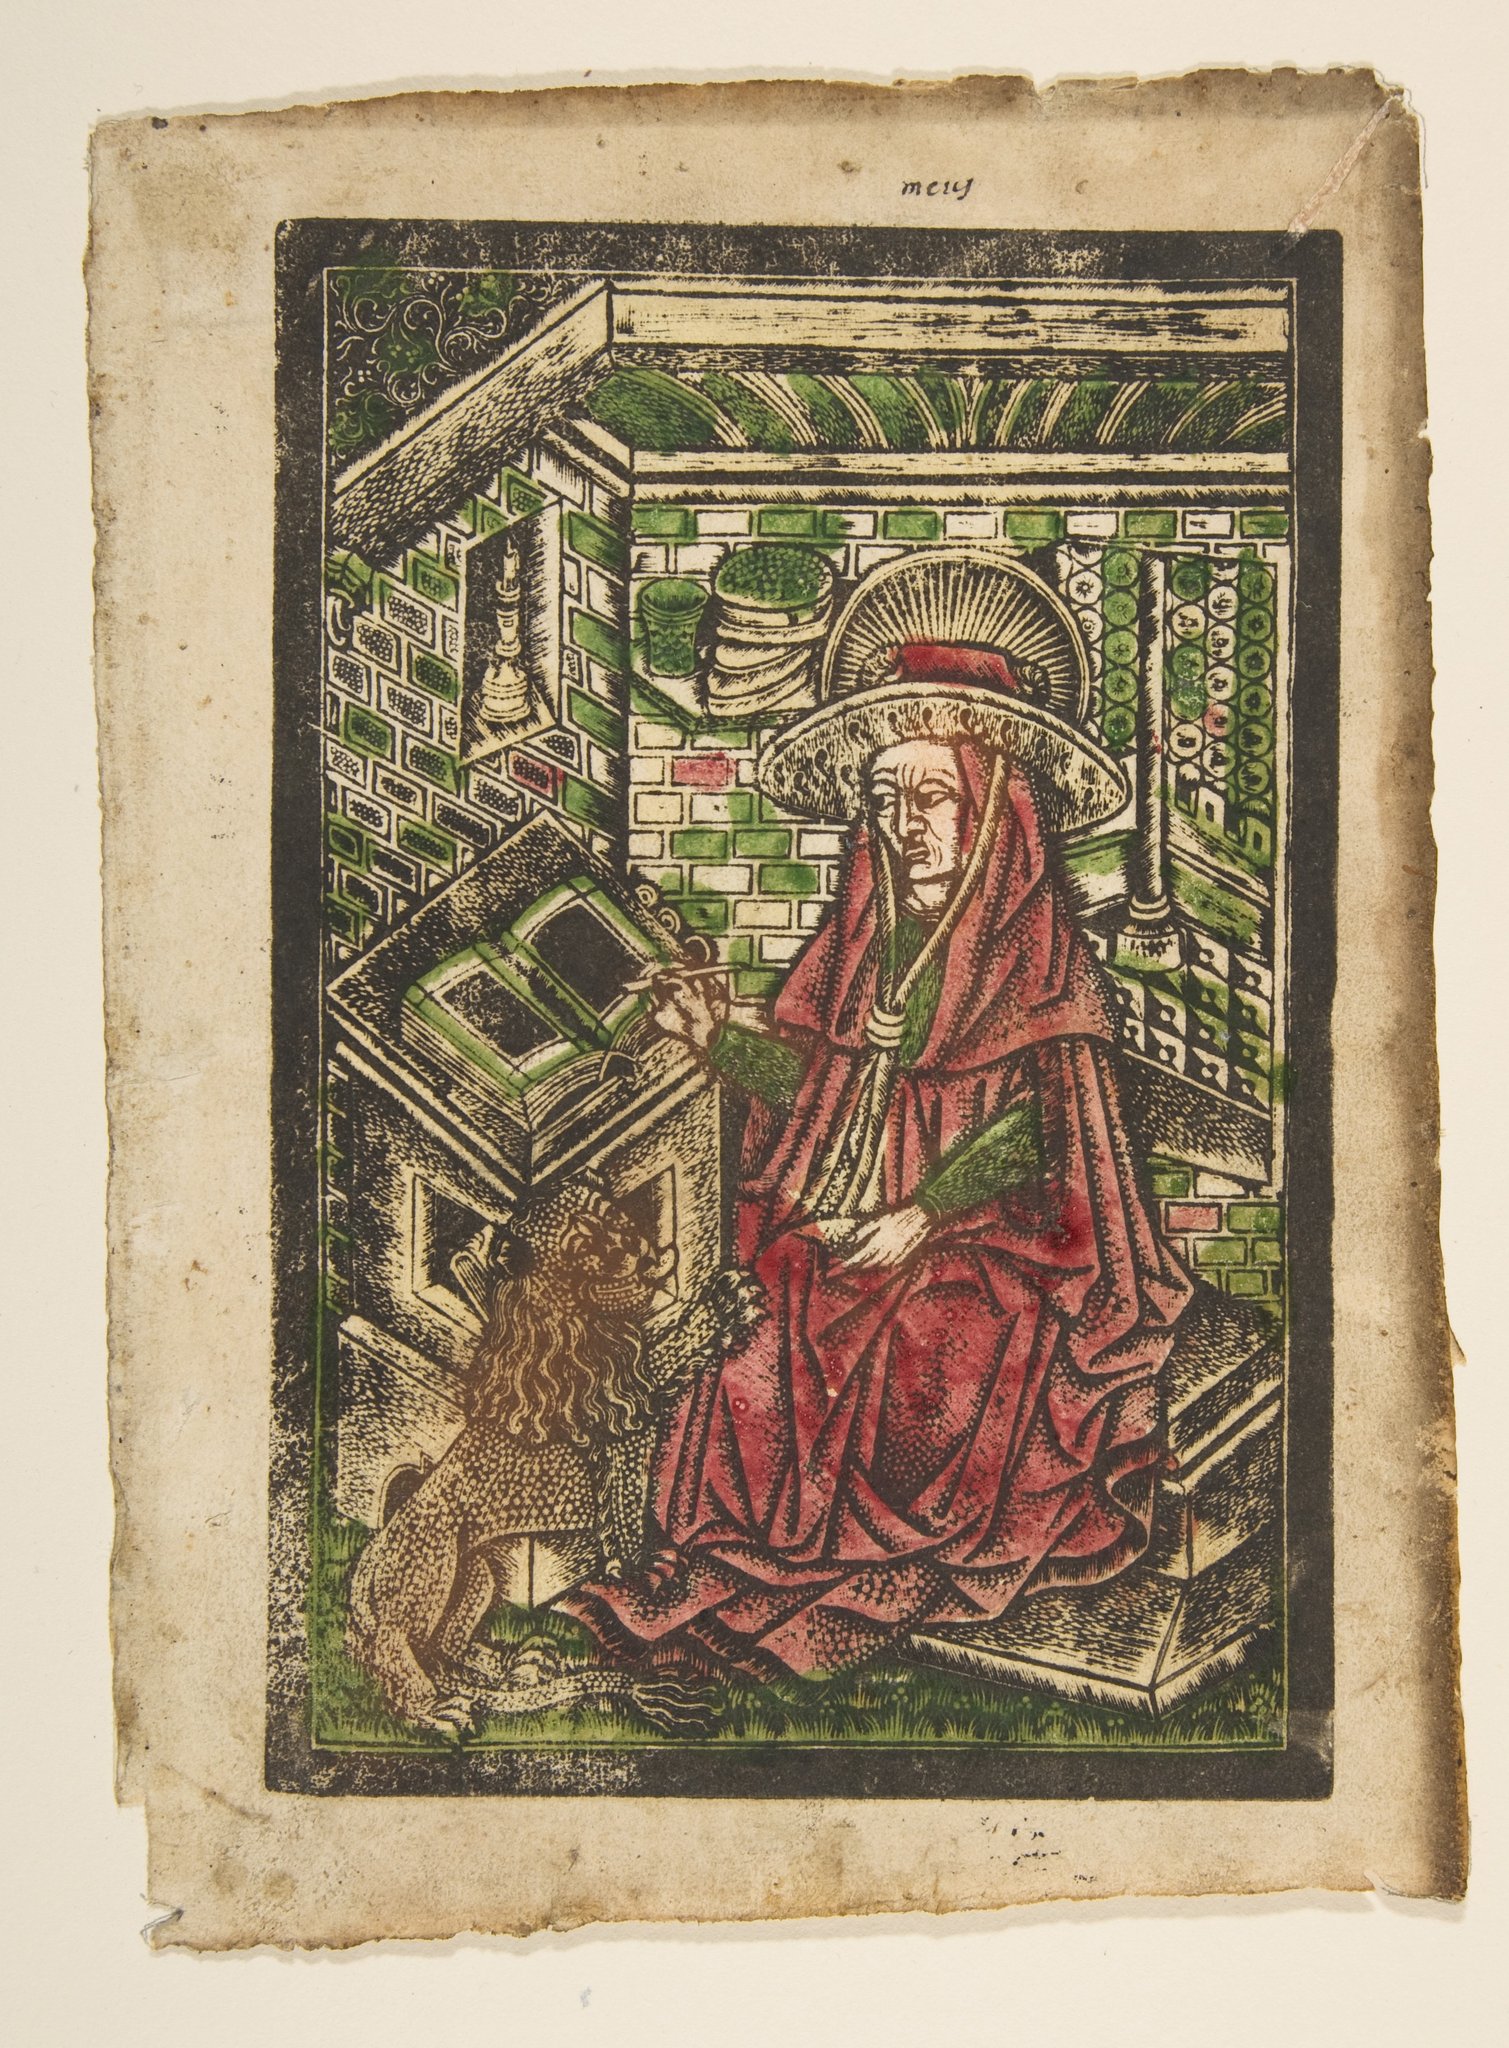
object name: print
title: St. Jerome in his Study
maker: anonymous, german, 15th century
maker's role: artist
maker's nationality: german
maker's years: 1400-1500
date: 1401-1500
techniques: hand coloring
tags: books,lions,saint jerome